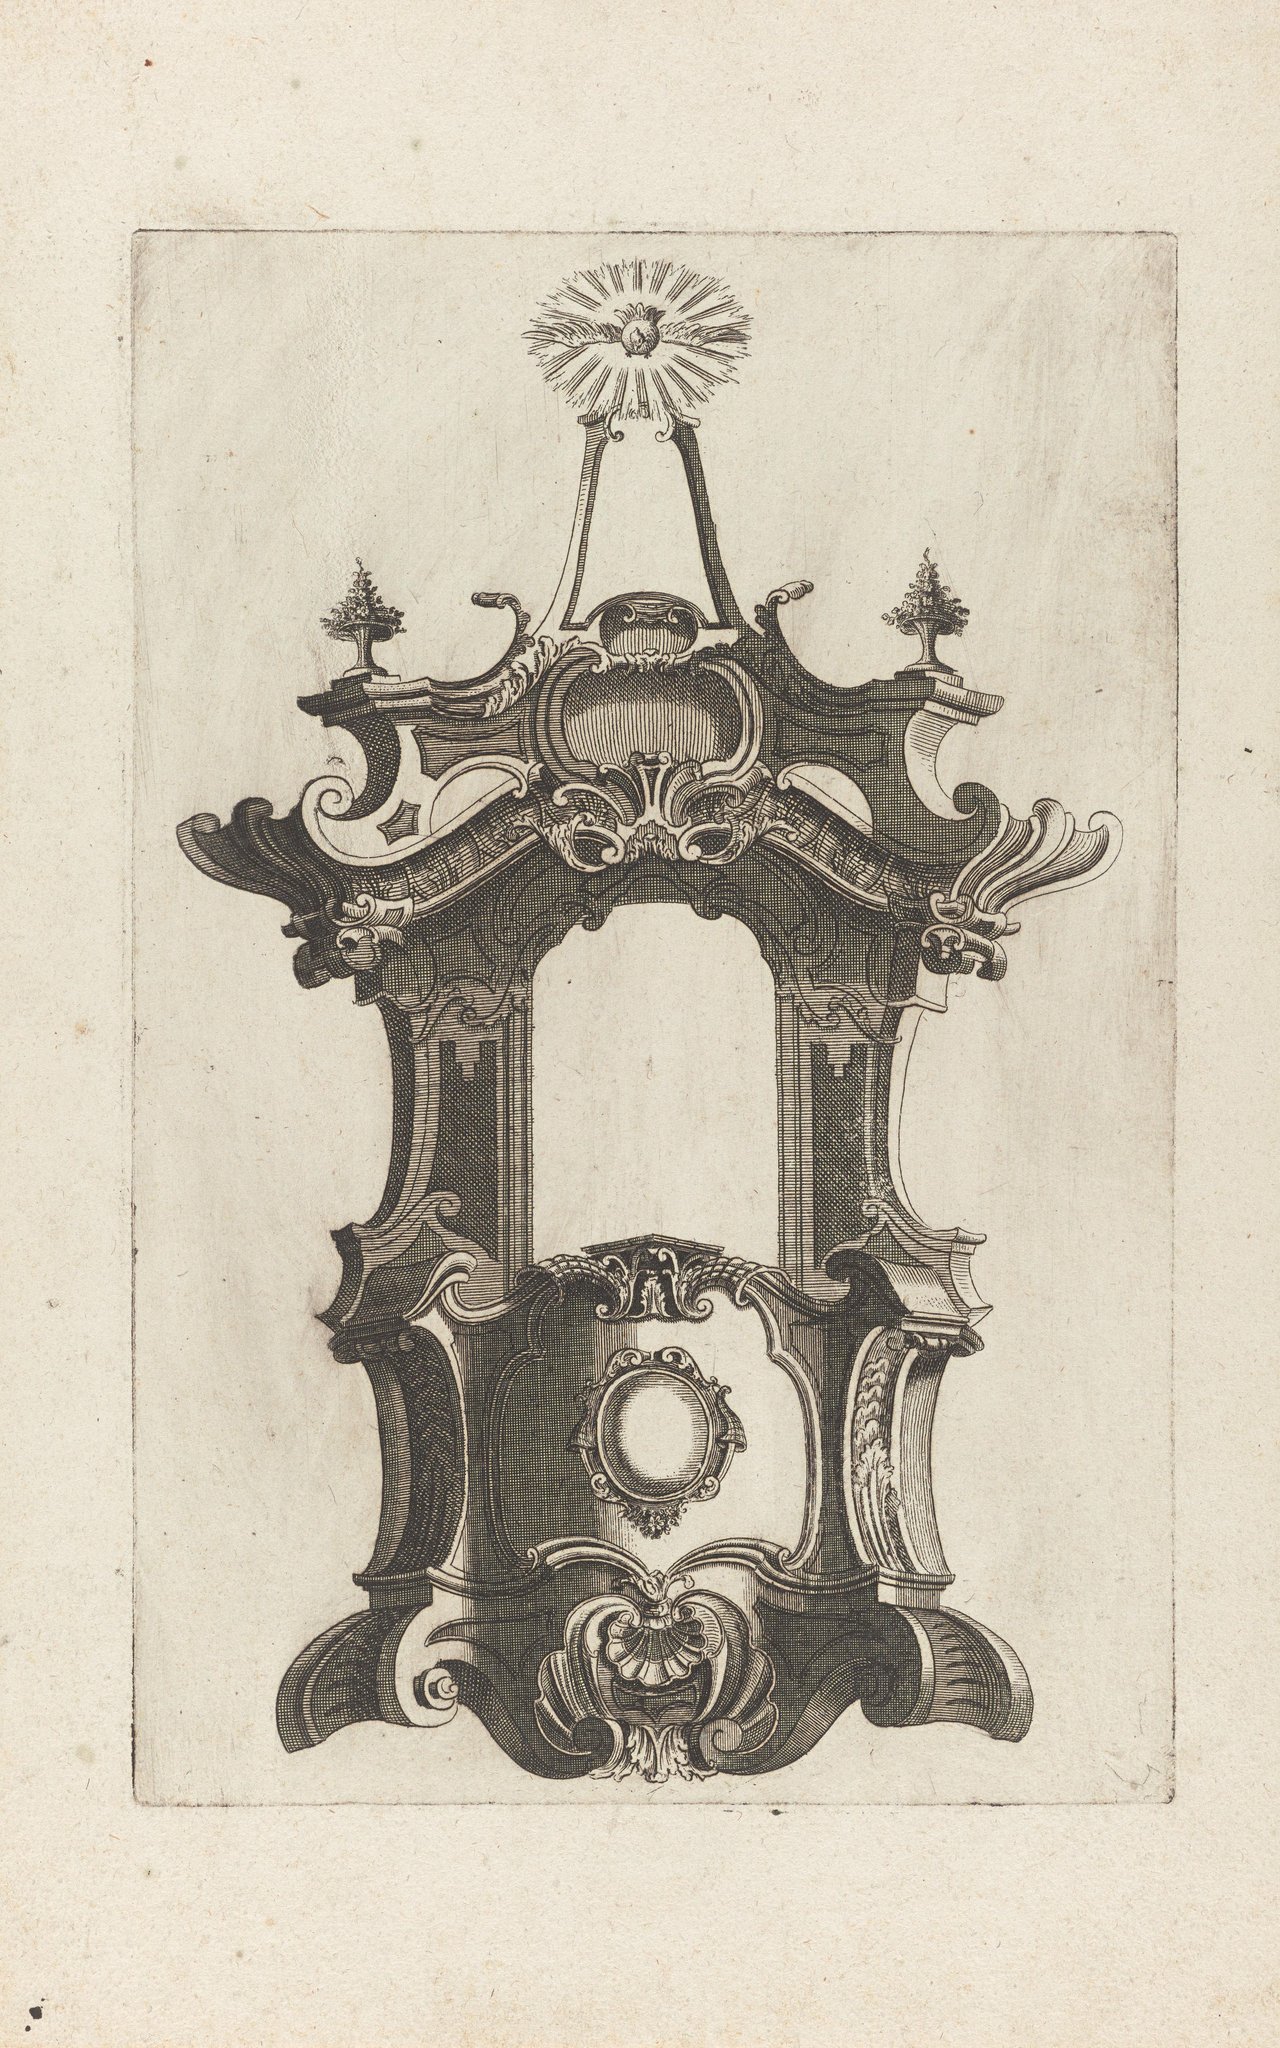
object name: ornament print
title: Preekstoel met de Heilige Geest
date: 1740-1762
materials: paper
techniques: engraving, etching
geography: augsburg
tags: rocaille ornament, pulpit, ambo, chancel, holy ghost represented as a dove (in flames)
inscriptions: collector's mark: Lugt 2760, collector's mark: Lugt 2228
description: Op de preekstoel de Heilige Geest in de gedaante van een duif in een stralenkrans.